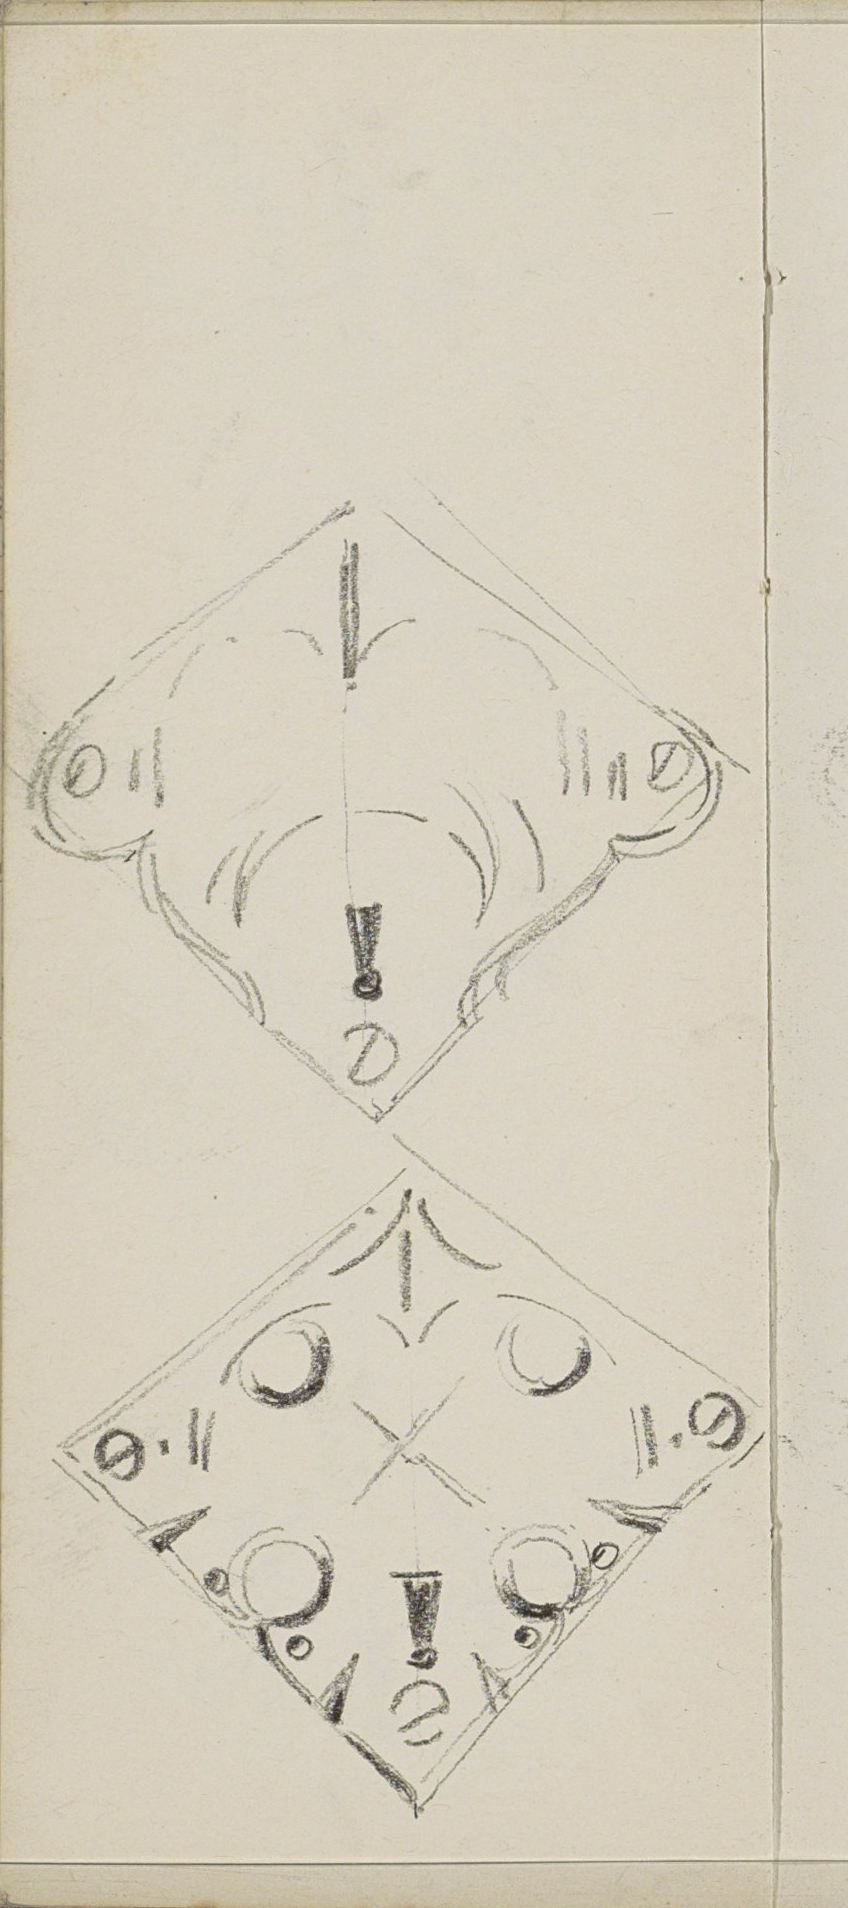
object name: sketchbook leaf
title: Ruitvormige ornamenten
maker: gerrit willem dijsselhof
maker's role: designer, draughtsman, print maker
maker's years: 1866-1924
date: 1876-1924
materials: chalk, paper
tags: ornaments ~ art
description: Blad 35 verso uit een schetsboek met 40 bladen.